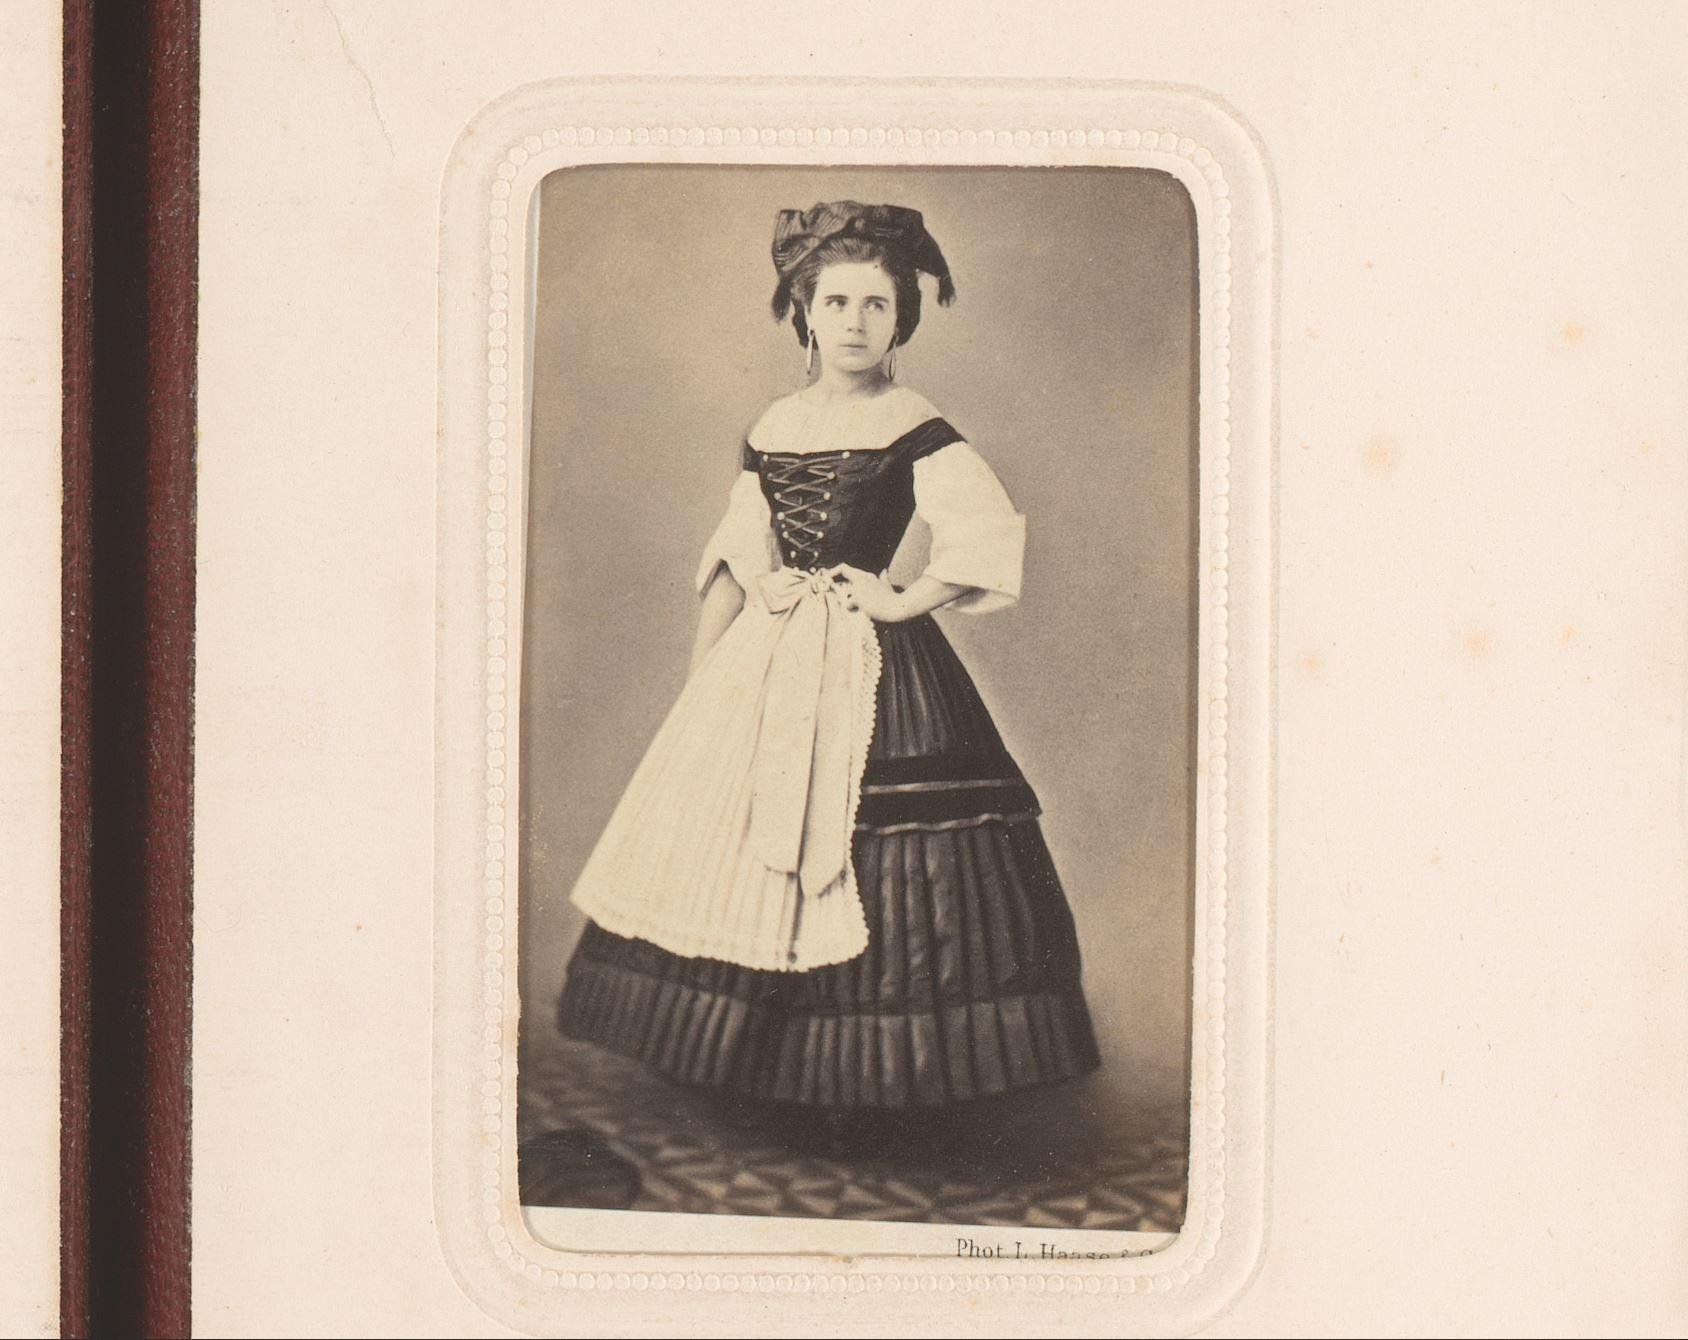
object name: carte de visite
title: Portret van een staande jonge vrouw in klederdracht uit Duitsland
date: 1860-1890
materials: cardboard, photographic support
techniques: albumen print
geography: breslau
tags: historical persons - bb - woman, folk costume, regional costume, standing figure - aa - female human figure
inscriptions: inscription: ‘178 Friederichstrasse Berlin 10 Tauenziehstrasse Breslau’